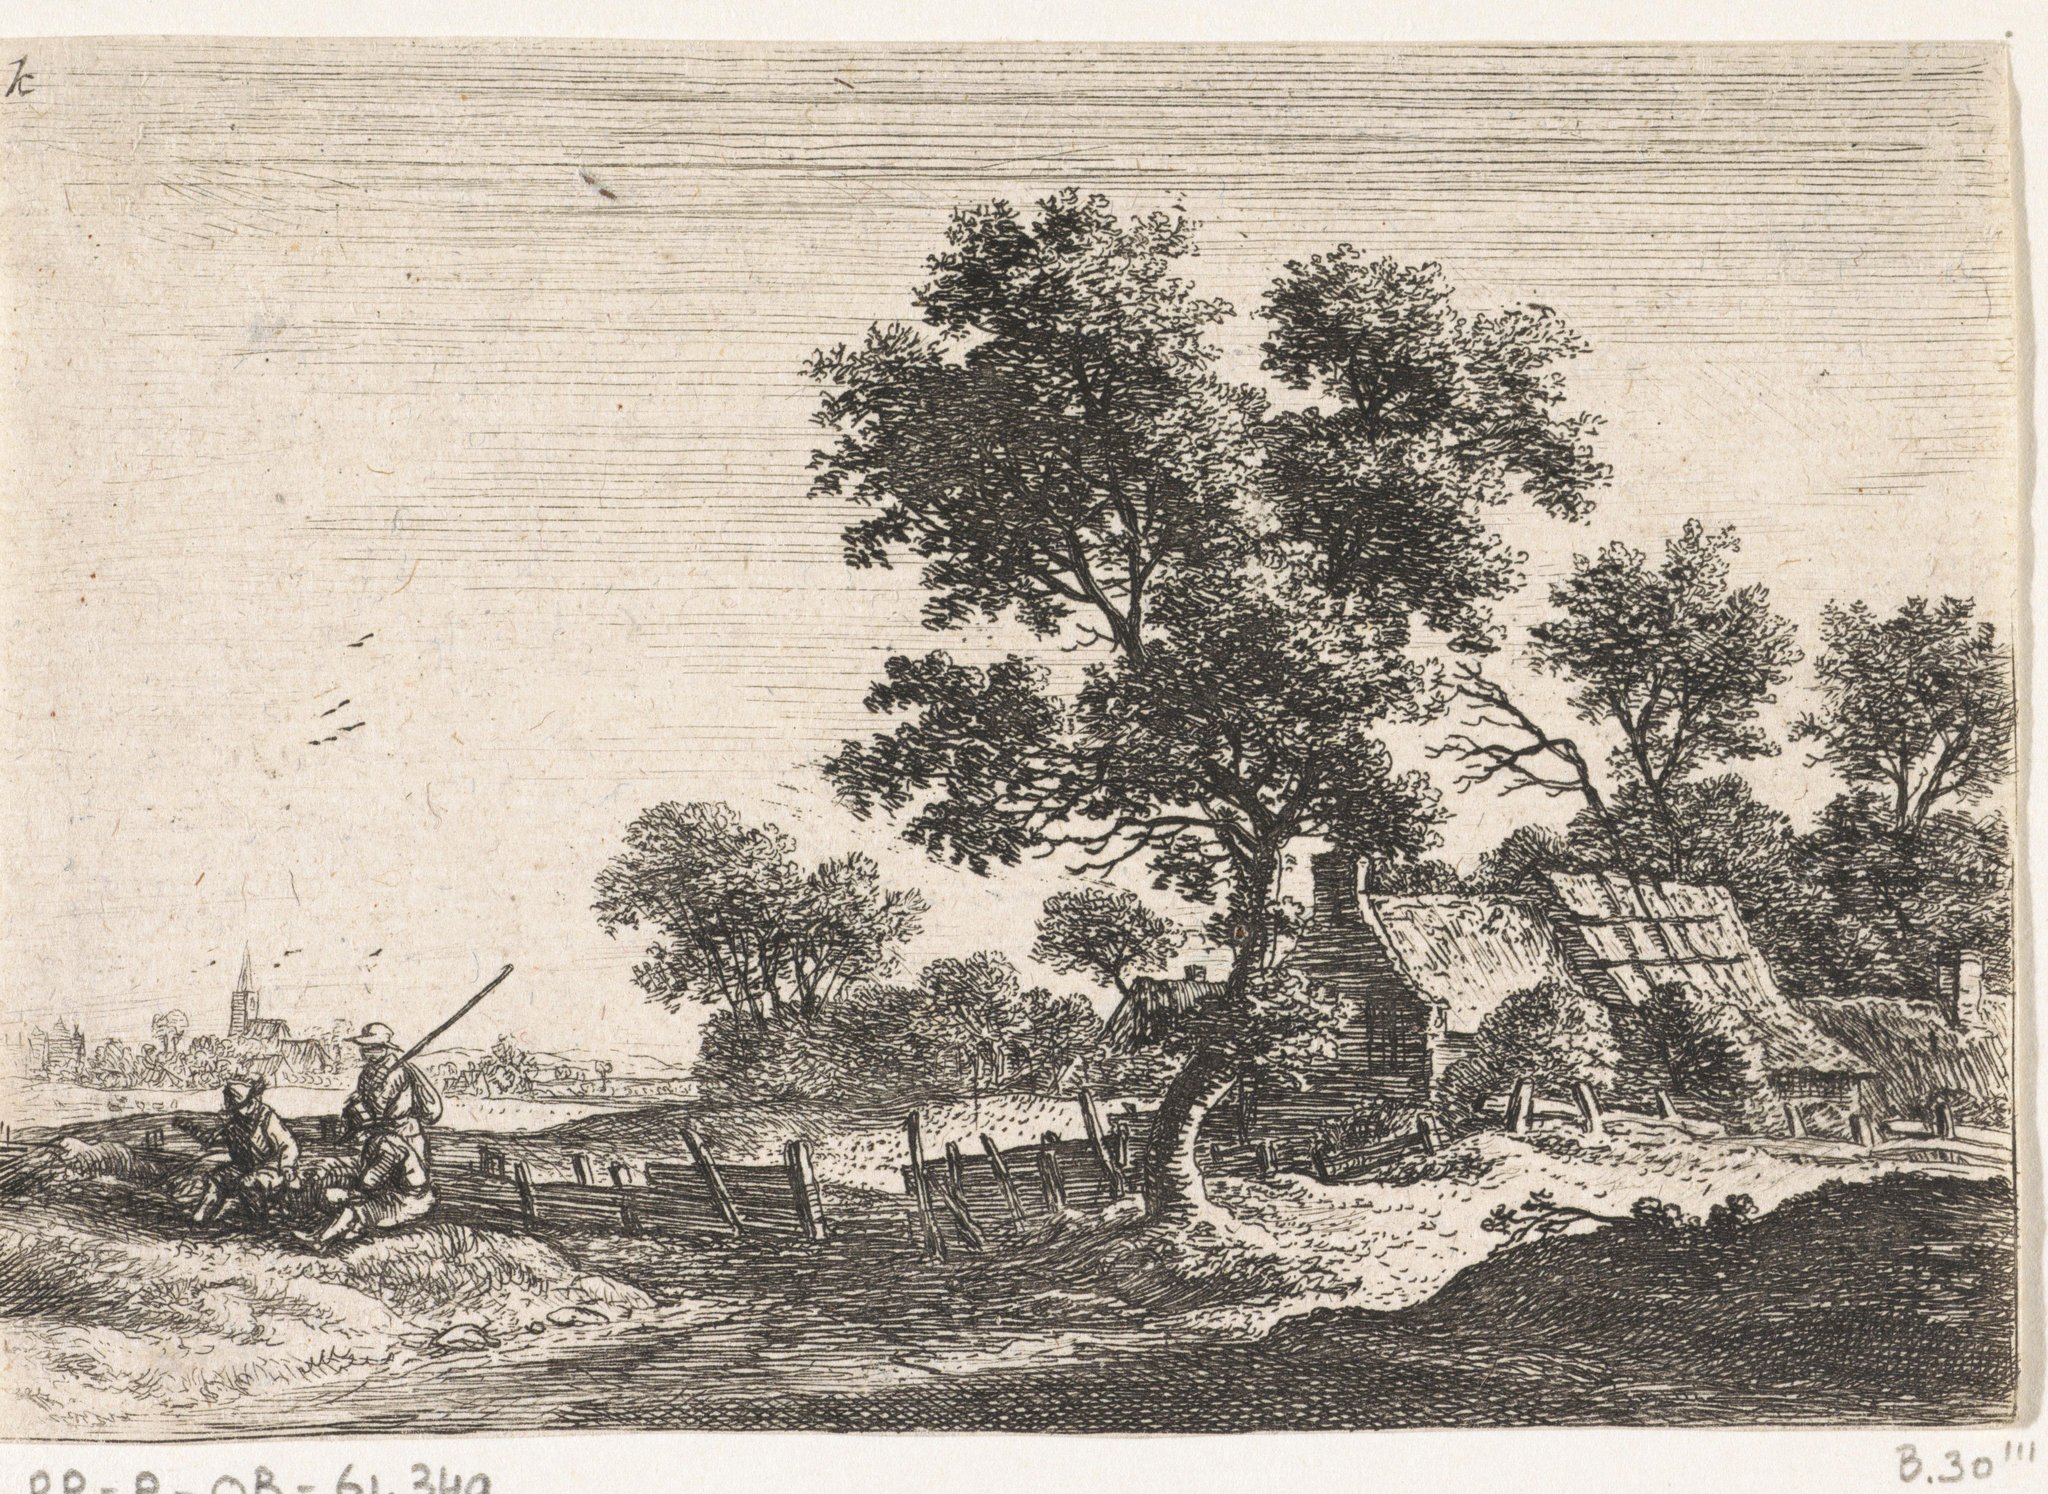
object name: print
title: Landschappen met figuren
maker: anthonie waterloo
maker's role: draughtsman, painter, print maker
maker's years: 1609-1690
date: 1630-1663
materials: paper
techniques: etching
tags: village, church (exterior), landscapes (+ landscape with figures, staffage)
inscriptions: collector's mark: Lugt 2228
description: Links zitten twee boeren op een heuvel voor een hek. Rechts ligt een dorp tussen de bomen. In de verte is een kerk weergegeven. Linksboven is de letter k te zien.